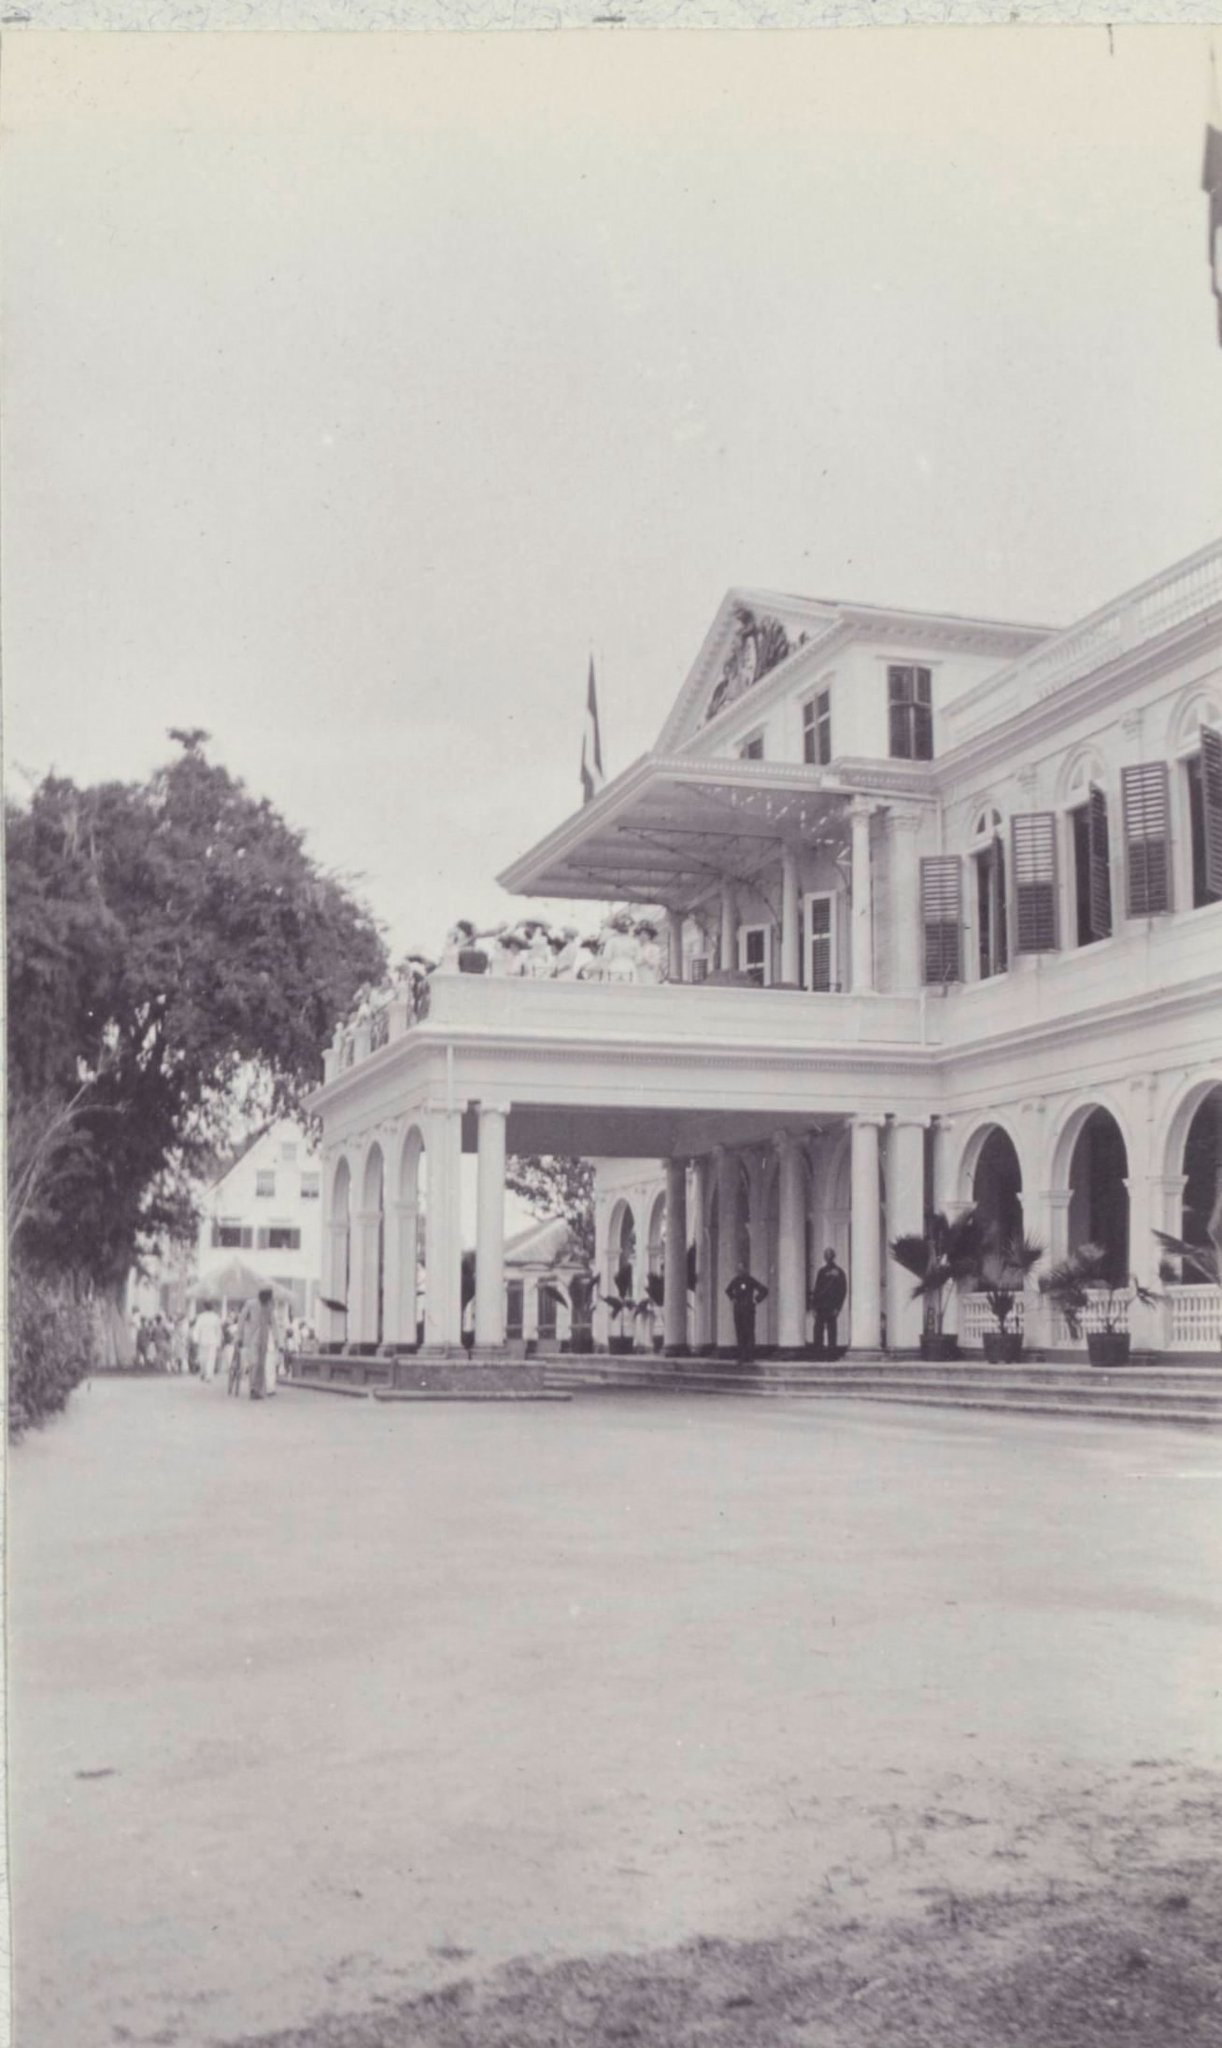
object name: photograph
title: Gouverneurspaleis te Paramaribo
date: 1905-1912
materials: photographic support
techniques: photography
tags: national government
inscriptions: inscription: ‘Curaçao Mei 1912’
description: Gezicht op het Gouverneurspaleis te Paramaribo, mei 1912. Onderdeel van het fotoalbum van de familie Boom-Gonggrijp in Suriname en Curaçao.